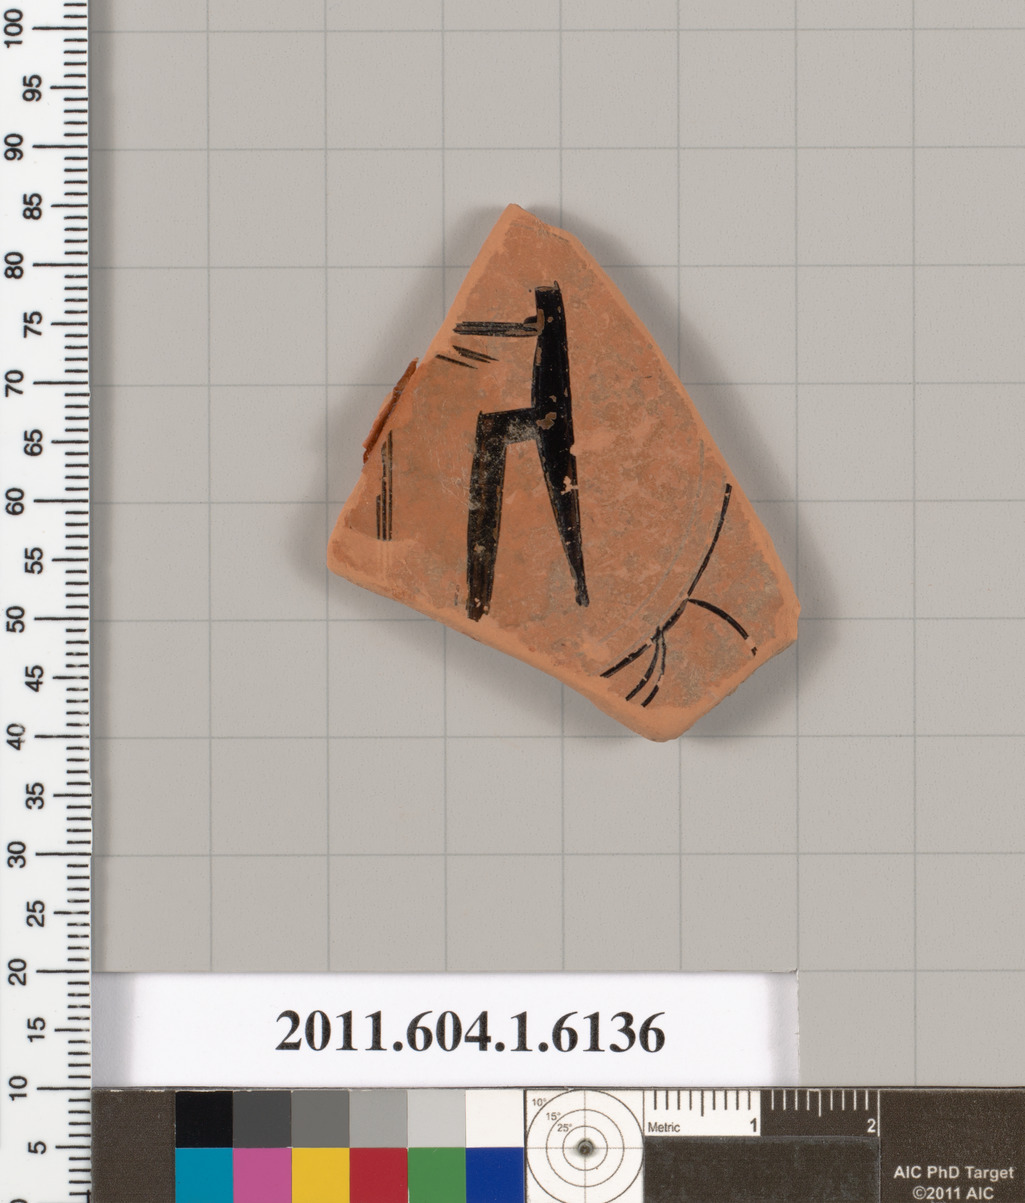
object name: kylix fragment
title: Terracotta fragment of a kylix (drinking cup)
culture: greek, attic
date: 520-500 BCE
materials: terracotta